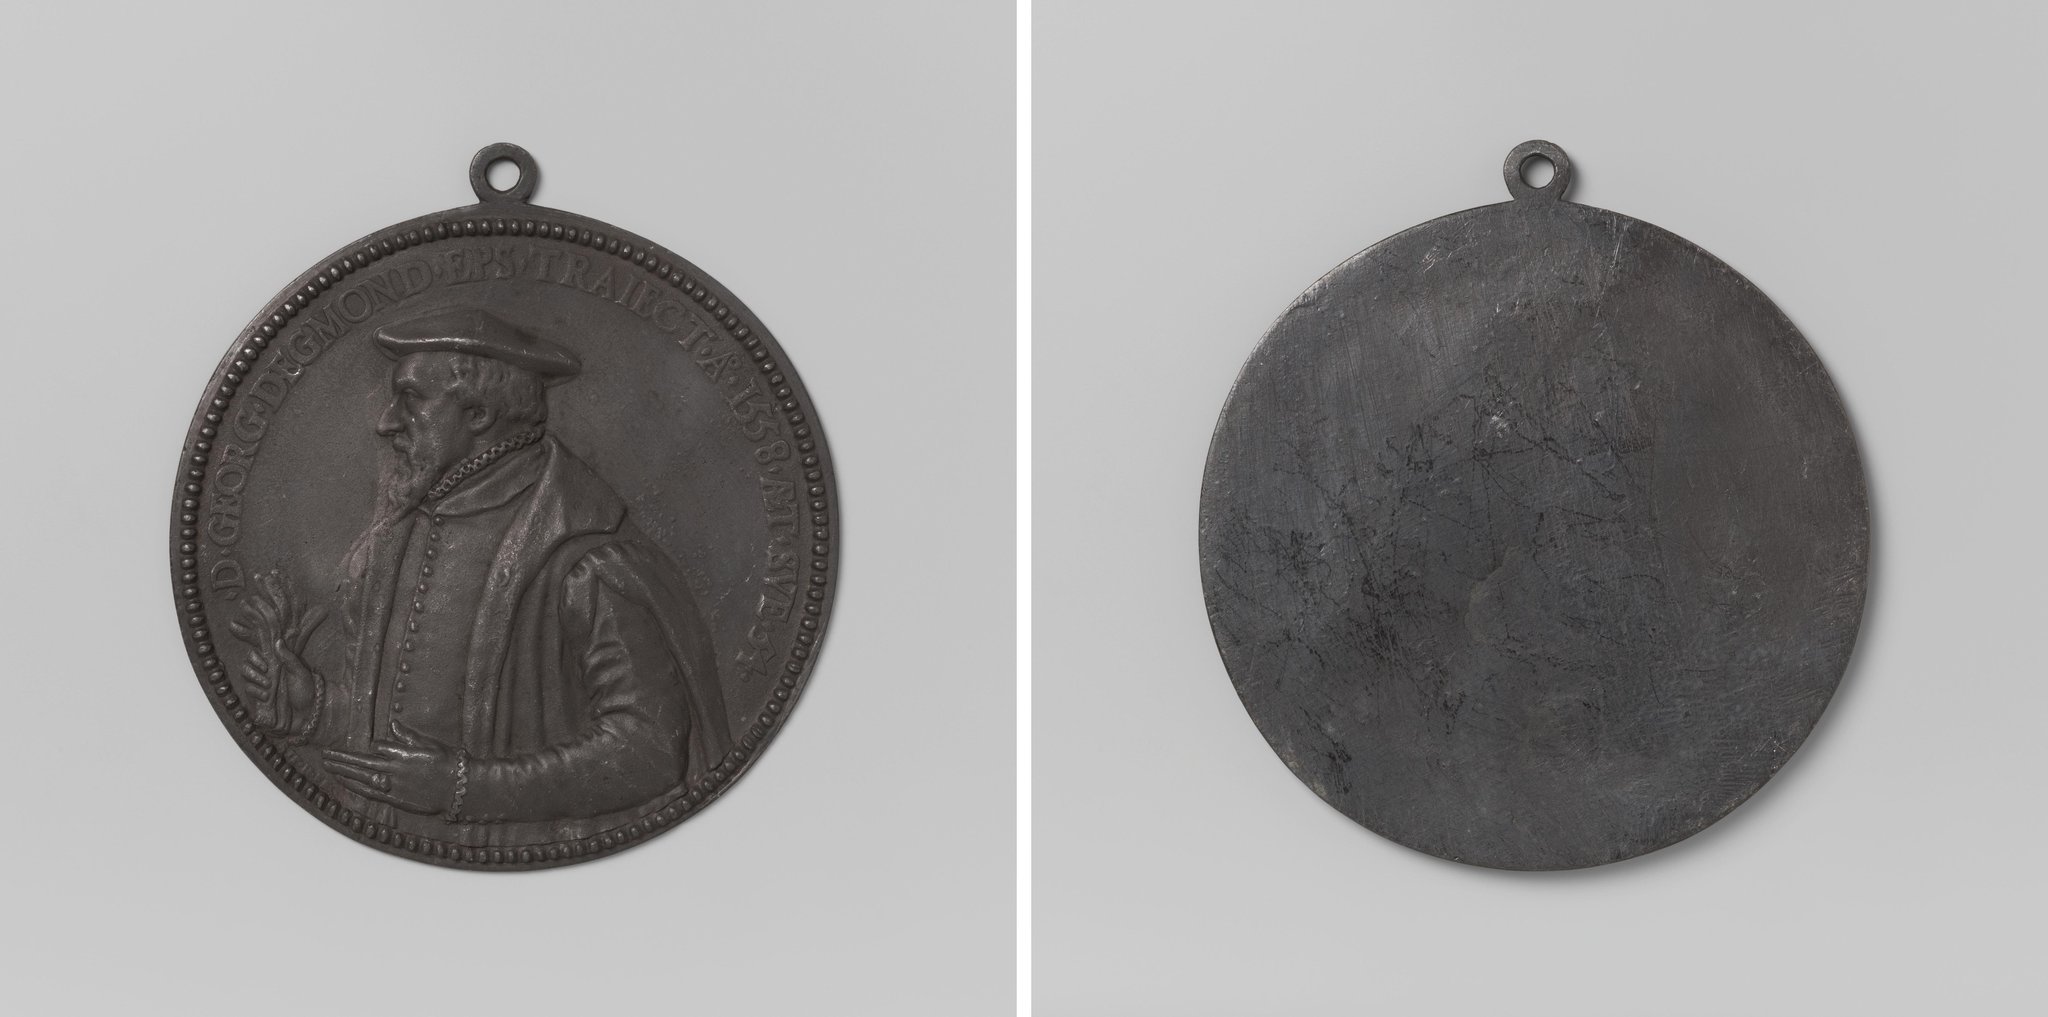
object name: plaque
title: George van Egmond, zestigste bisschop van Utrecht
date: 1558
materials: lead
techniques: casting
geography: antwerp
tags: george van egmond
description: eenzijdige plaquette aan draagoog. Voorzijde: borststuk man met muts op hoofd en paar handschoenen in rechterhand binnen omschrift. Keerzijde: blanco